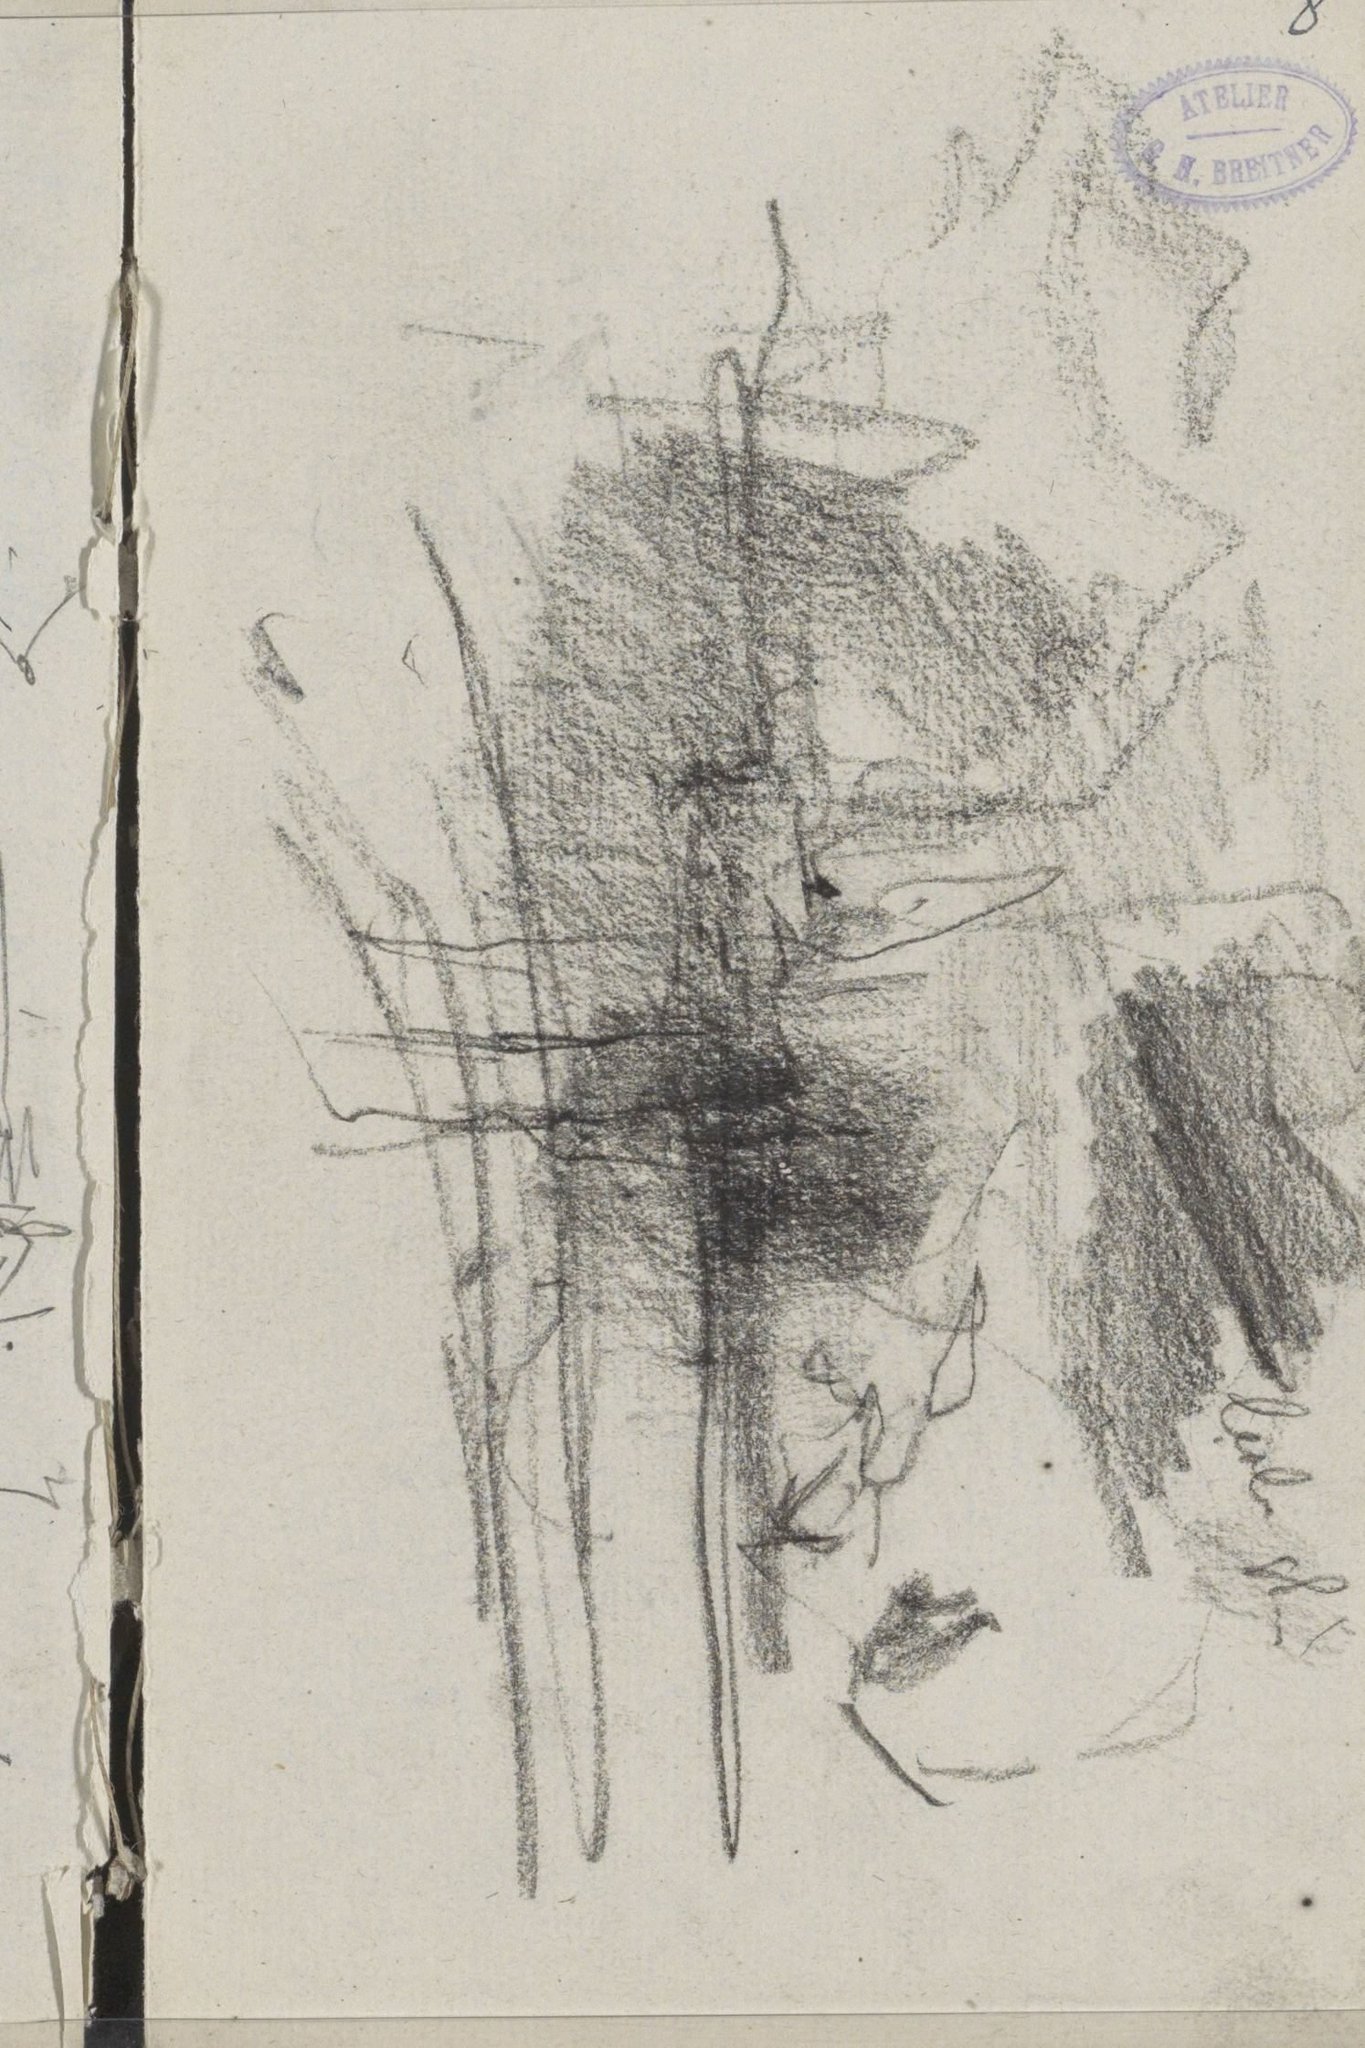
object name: sketchbook leaf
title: Landschap en een gezicht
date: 1880-1882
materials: chalk, paper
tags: face, landscapes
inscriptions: workshop stamp: Lugt 291d, annotation: ‘[...]’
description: Blad 8 recto uit een schetsboek met 10 bladen.